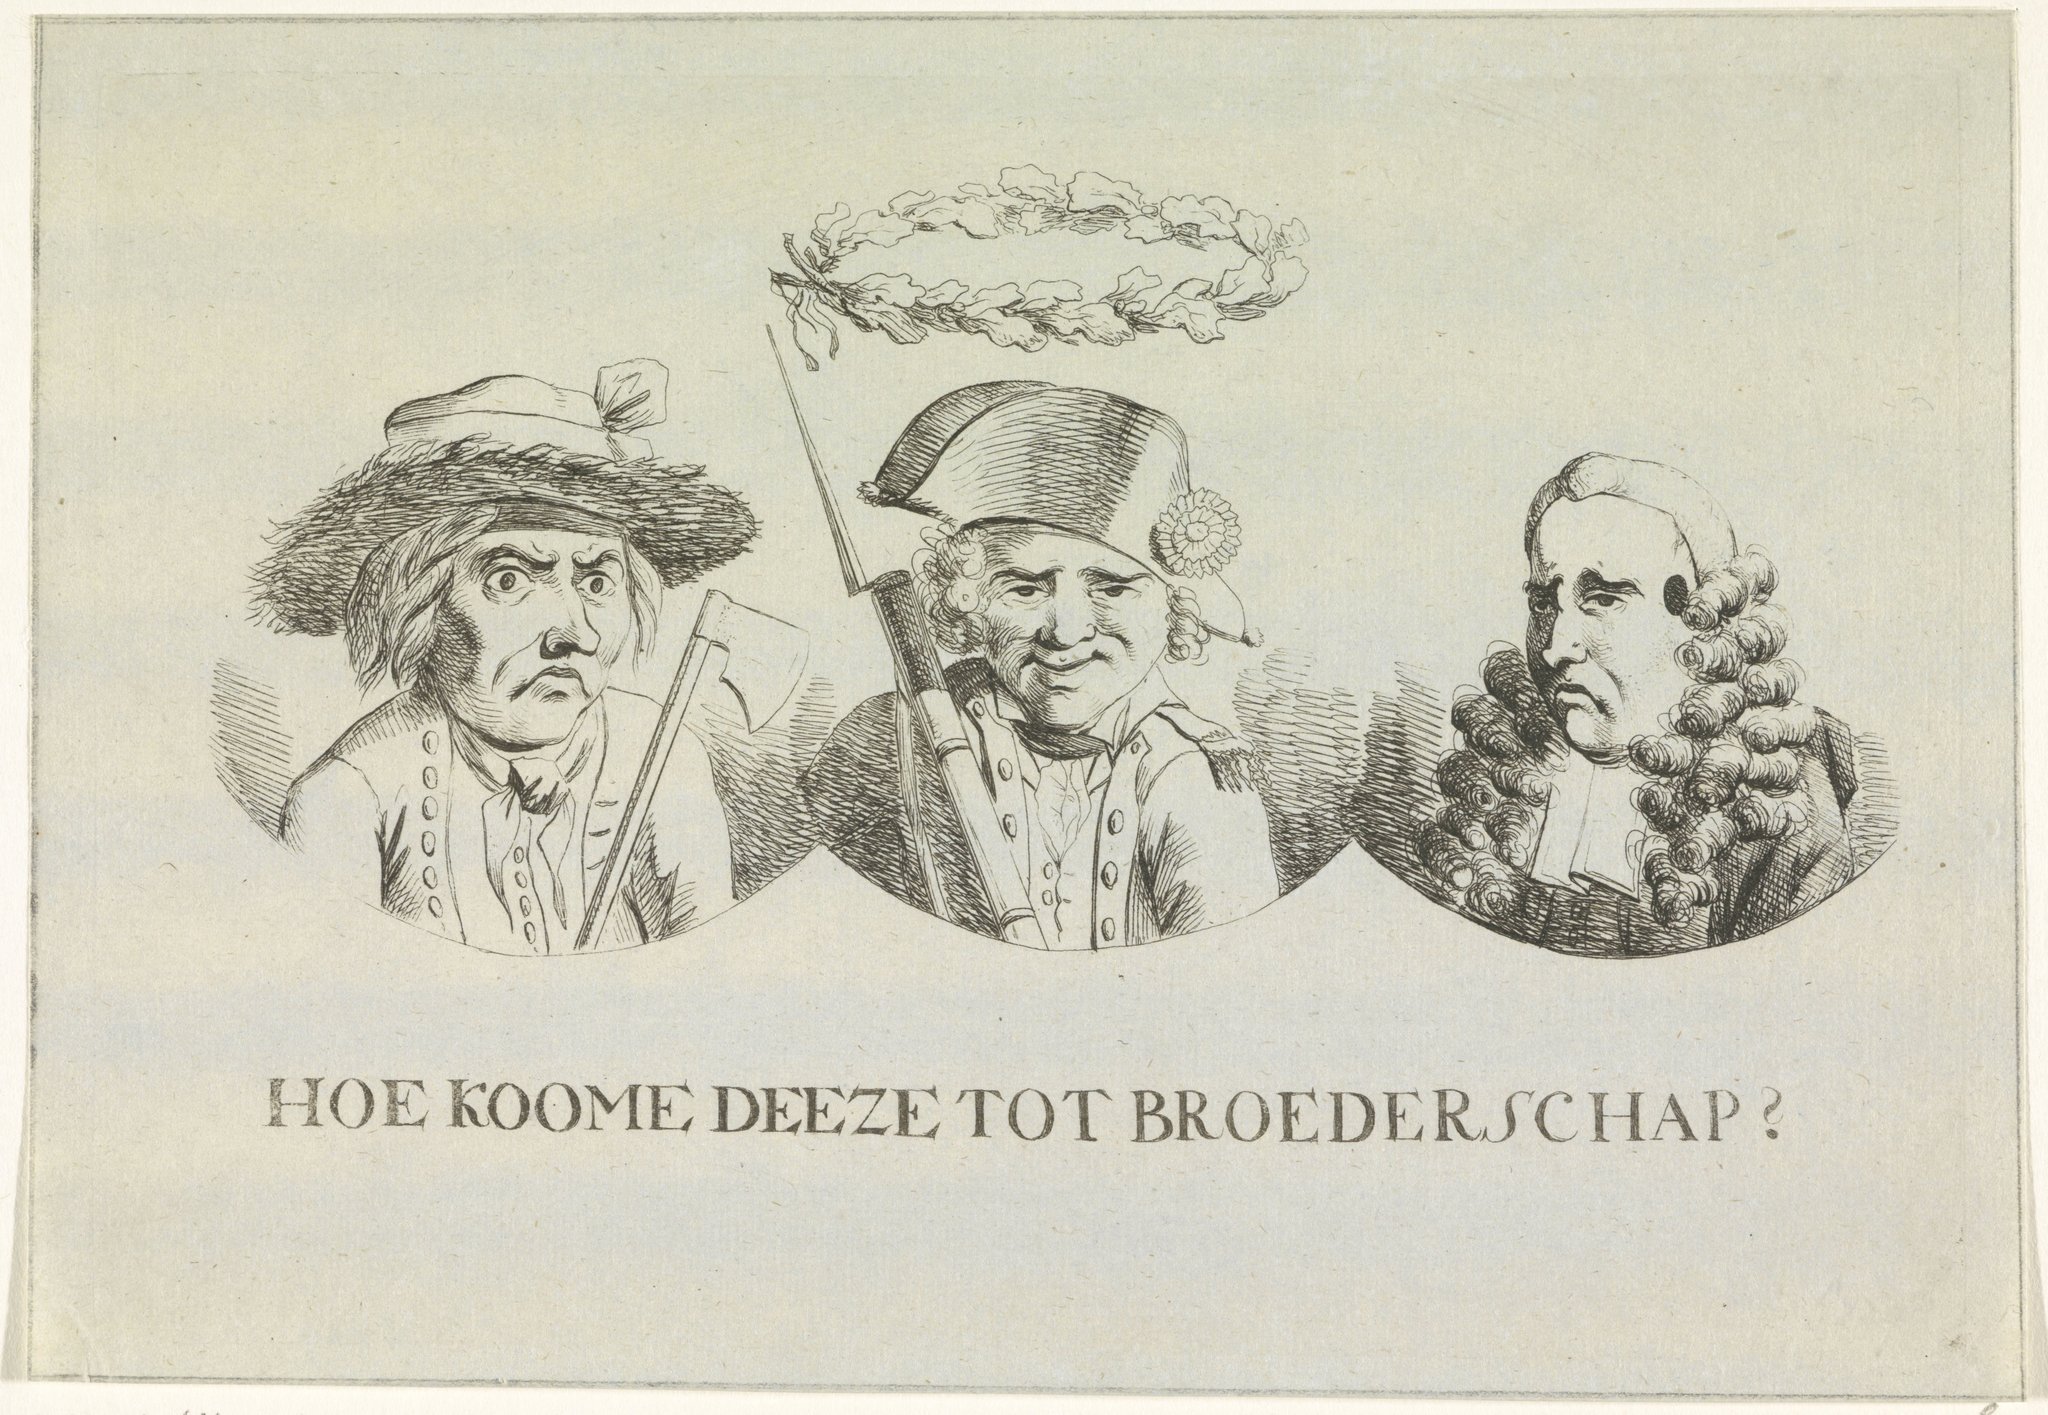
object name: print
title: Spotprent op de gelijkheid en broederschap, 1795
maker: hermanus fock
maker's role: conservator, draughtsman, painter, print maker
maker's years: 1766-1822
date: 1795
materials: paper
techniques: engraving, etching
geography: netherlands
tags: brotherly love, alliance with france (1795)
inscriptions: collector's mark: Lugt 2228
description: Spotprent op de gelijkheid en broederschap, 1795. Drie borstbeelden naast elkaar. Links een boos kijkende Oranjegezinde man met een bijl, waarschijnlijk een scheepstimmerman (of een boer). In het midden een blij kijkende republiekeinse soldaat, boven zijn hoofd een eikenkrans. Rechts een somber kijkende burgemeester of predikant met pruik.